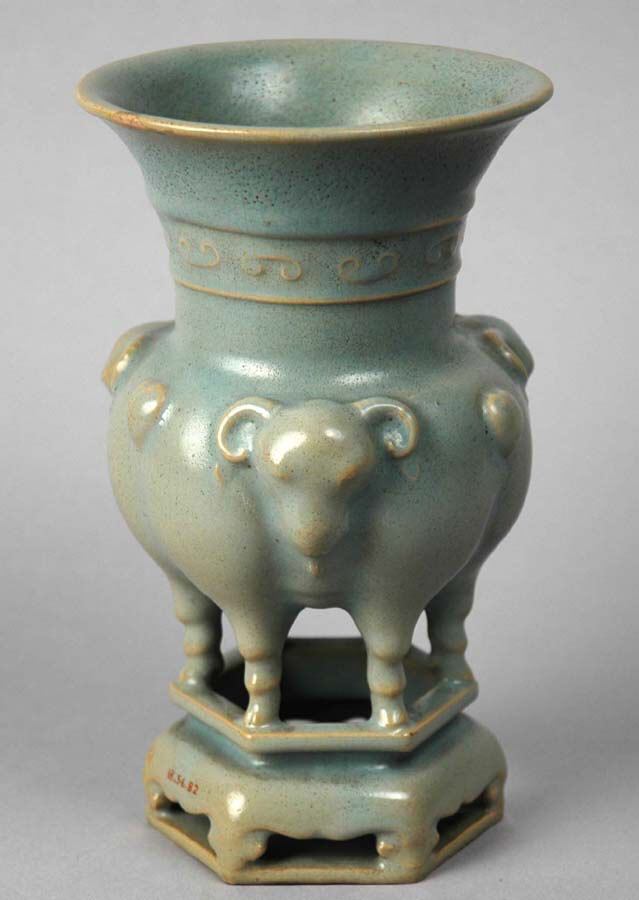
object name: vase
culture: chinese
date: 960-1279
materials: pottery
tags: bulls